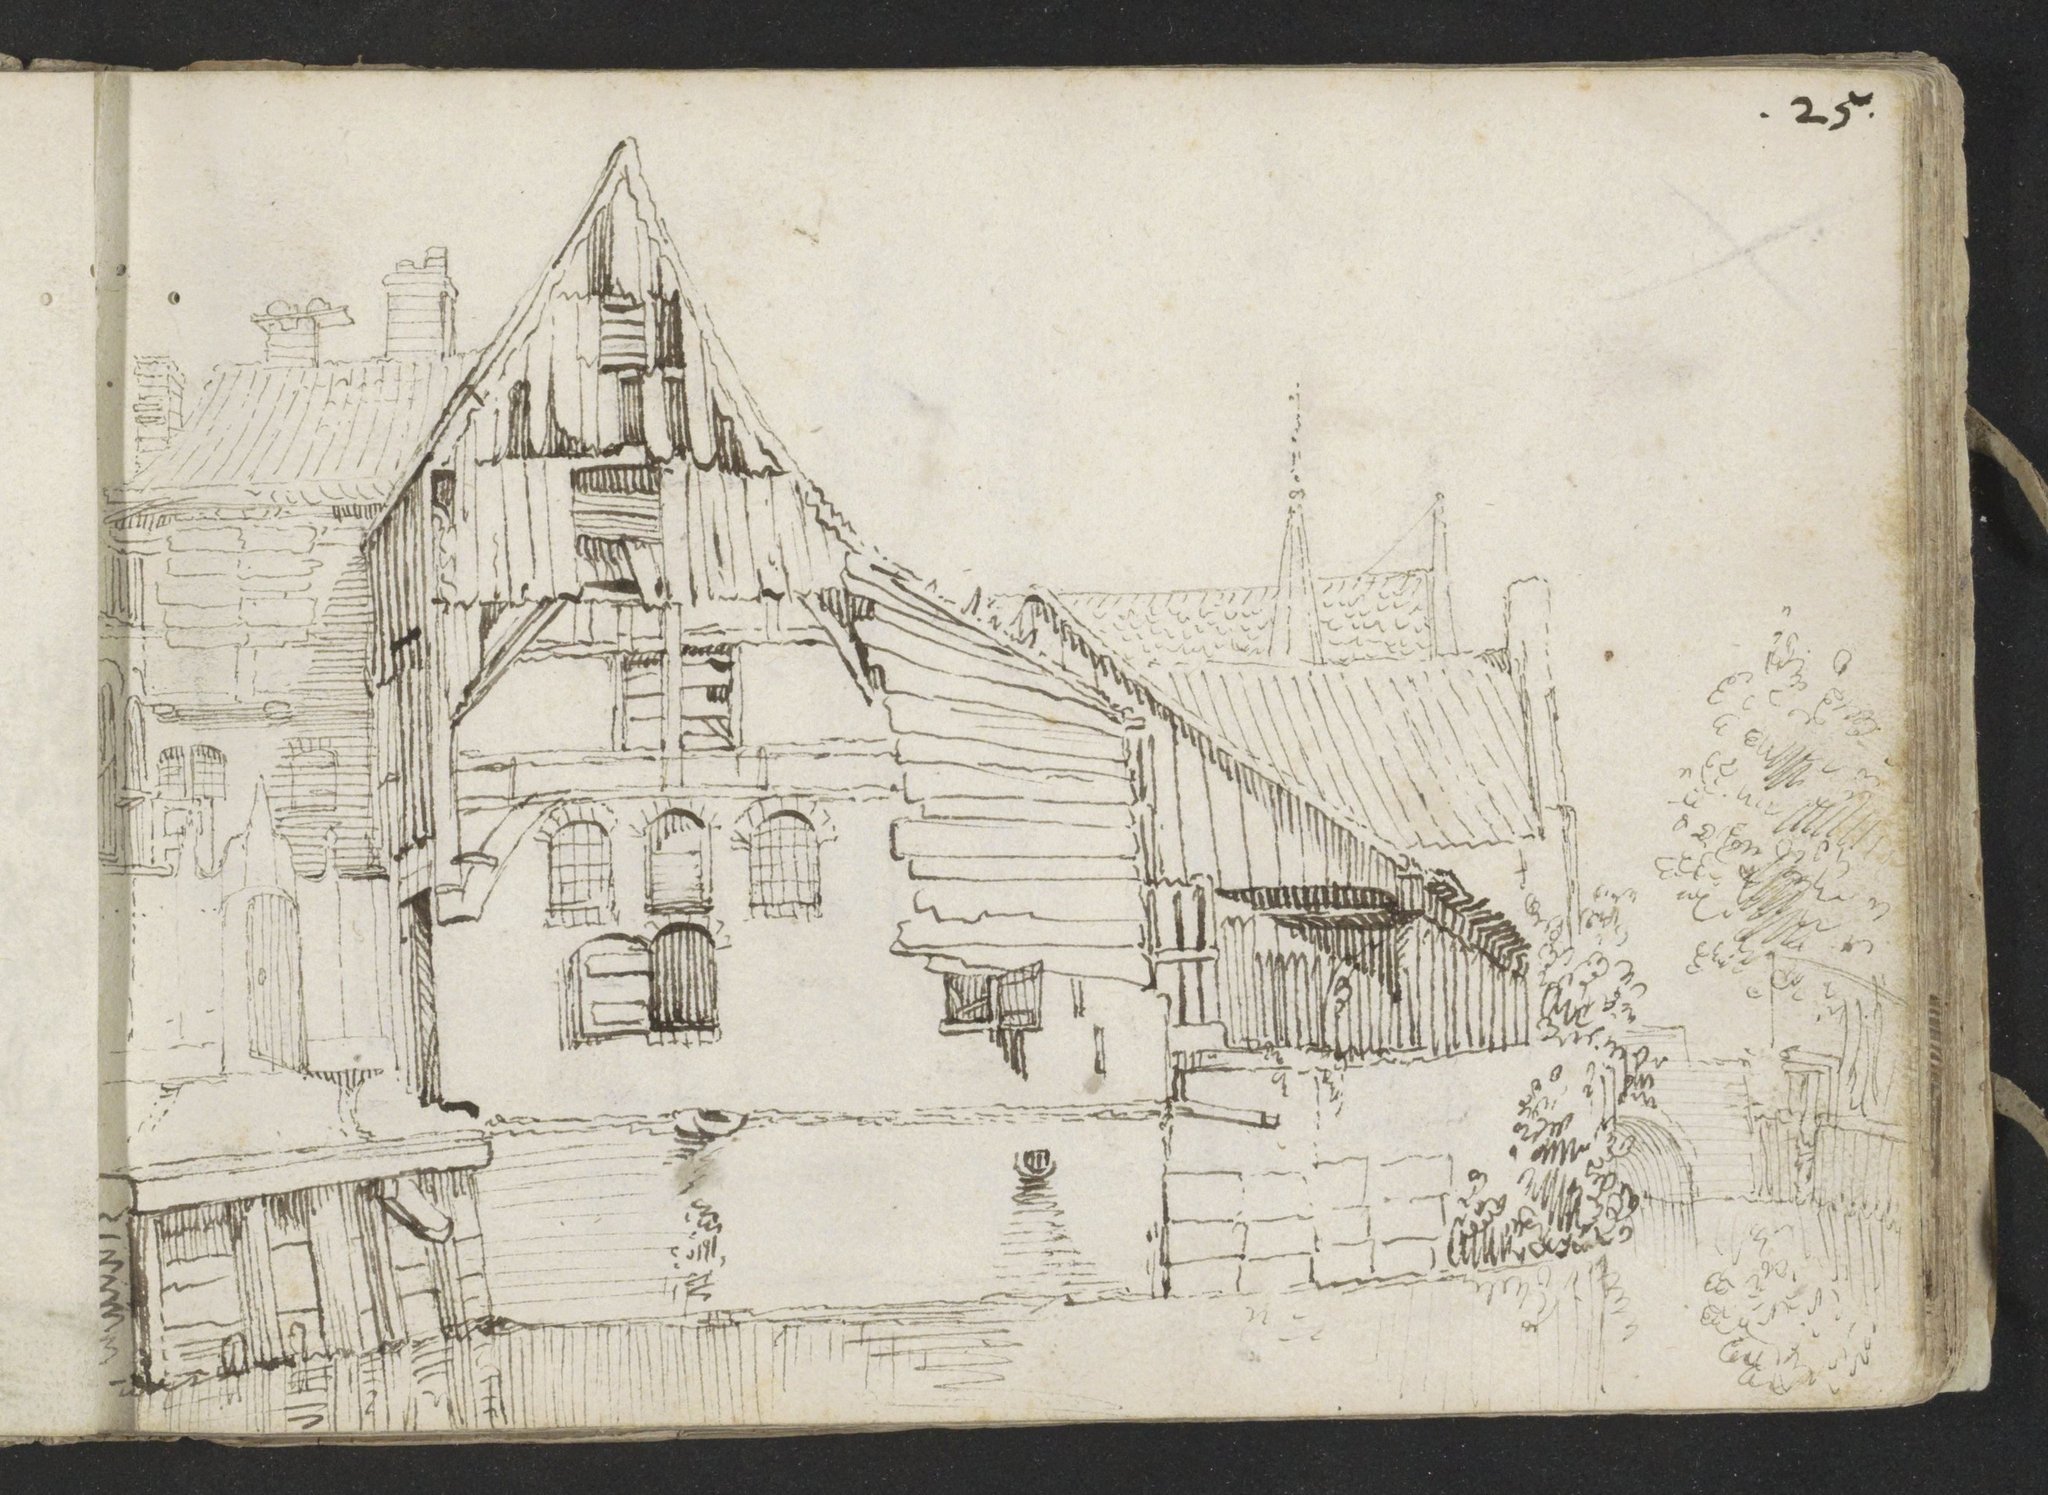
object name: sketchbook leaf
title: Vervallen woning aan de Grote Aa te Zwolle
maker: gerard ter borch (ii)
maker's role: draughtsman, painter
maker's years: 1617-1681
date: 1631-1633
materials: ink, paper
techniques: pen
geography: zwolle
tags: the usual house or row of houses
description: Op de achtergrond het Binnengasthuis. Blad 25 recto uit een schetsboek met 55 bladen.